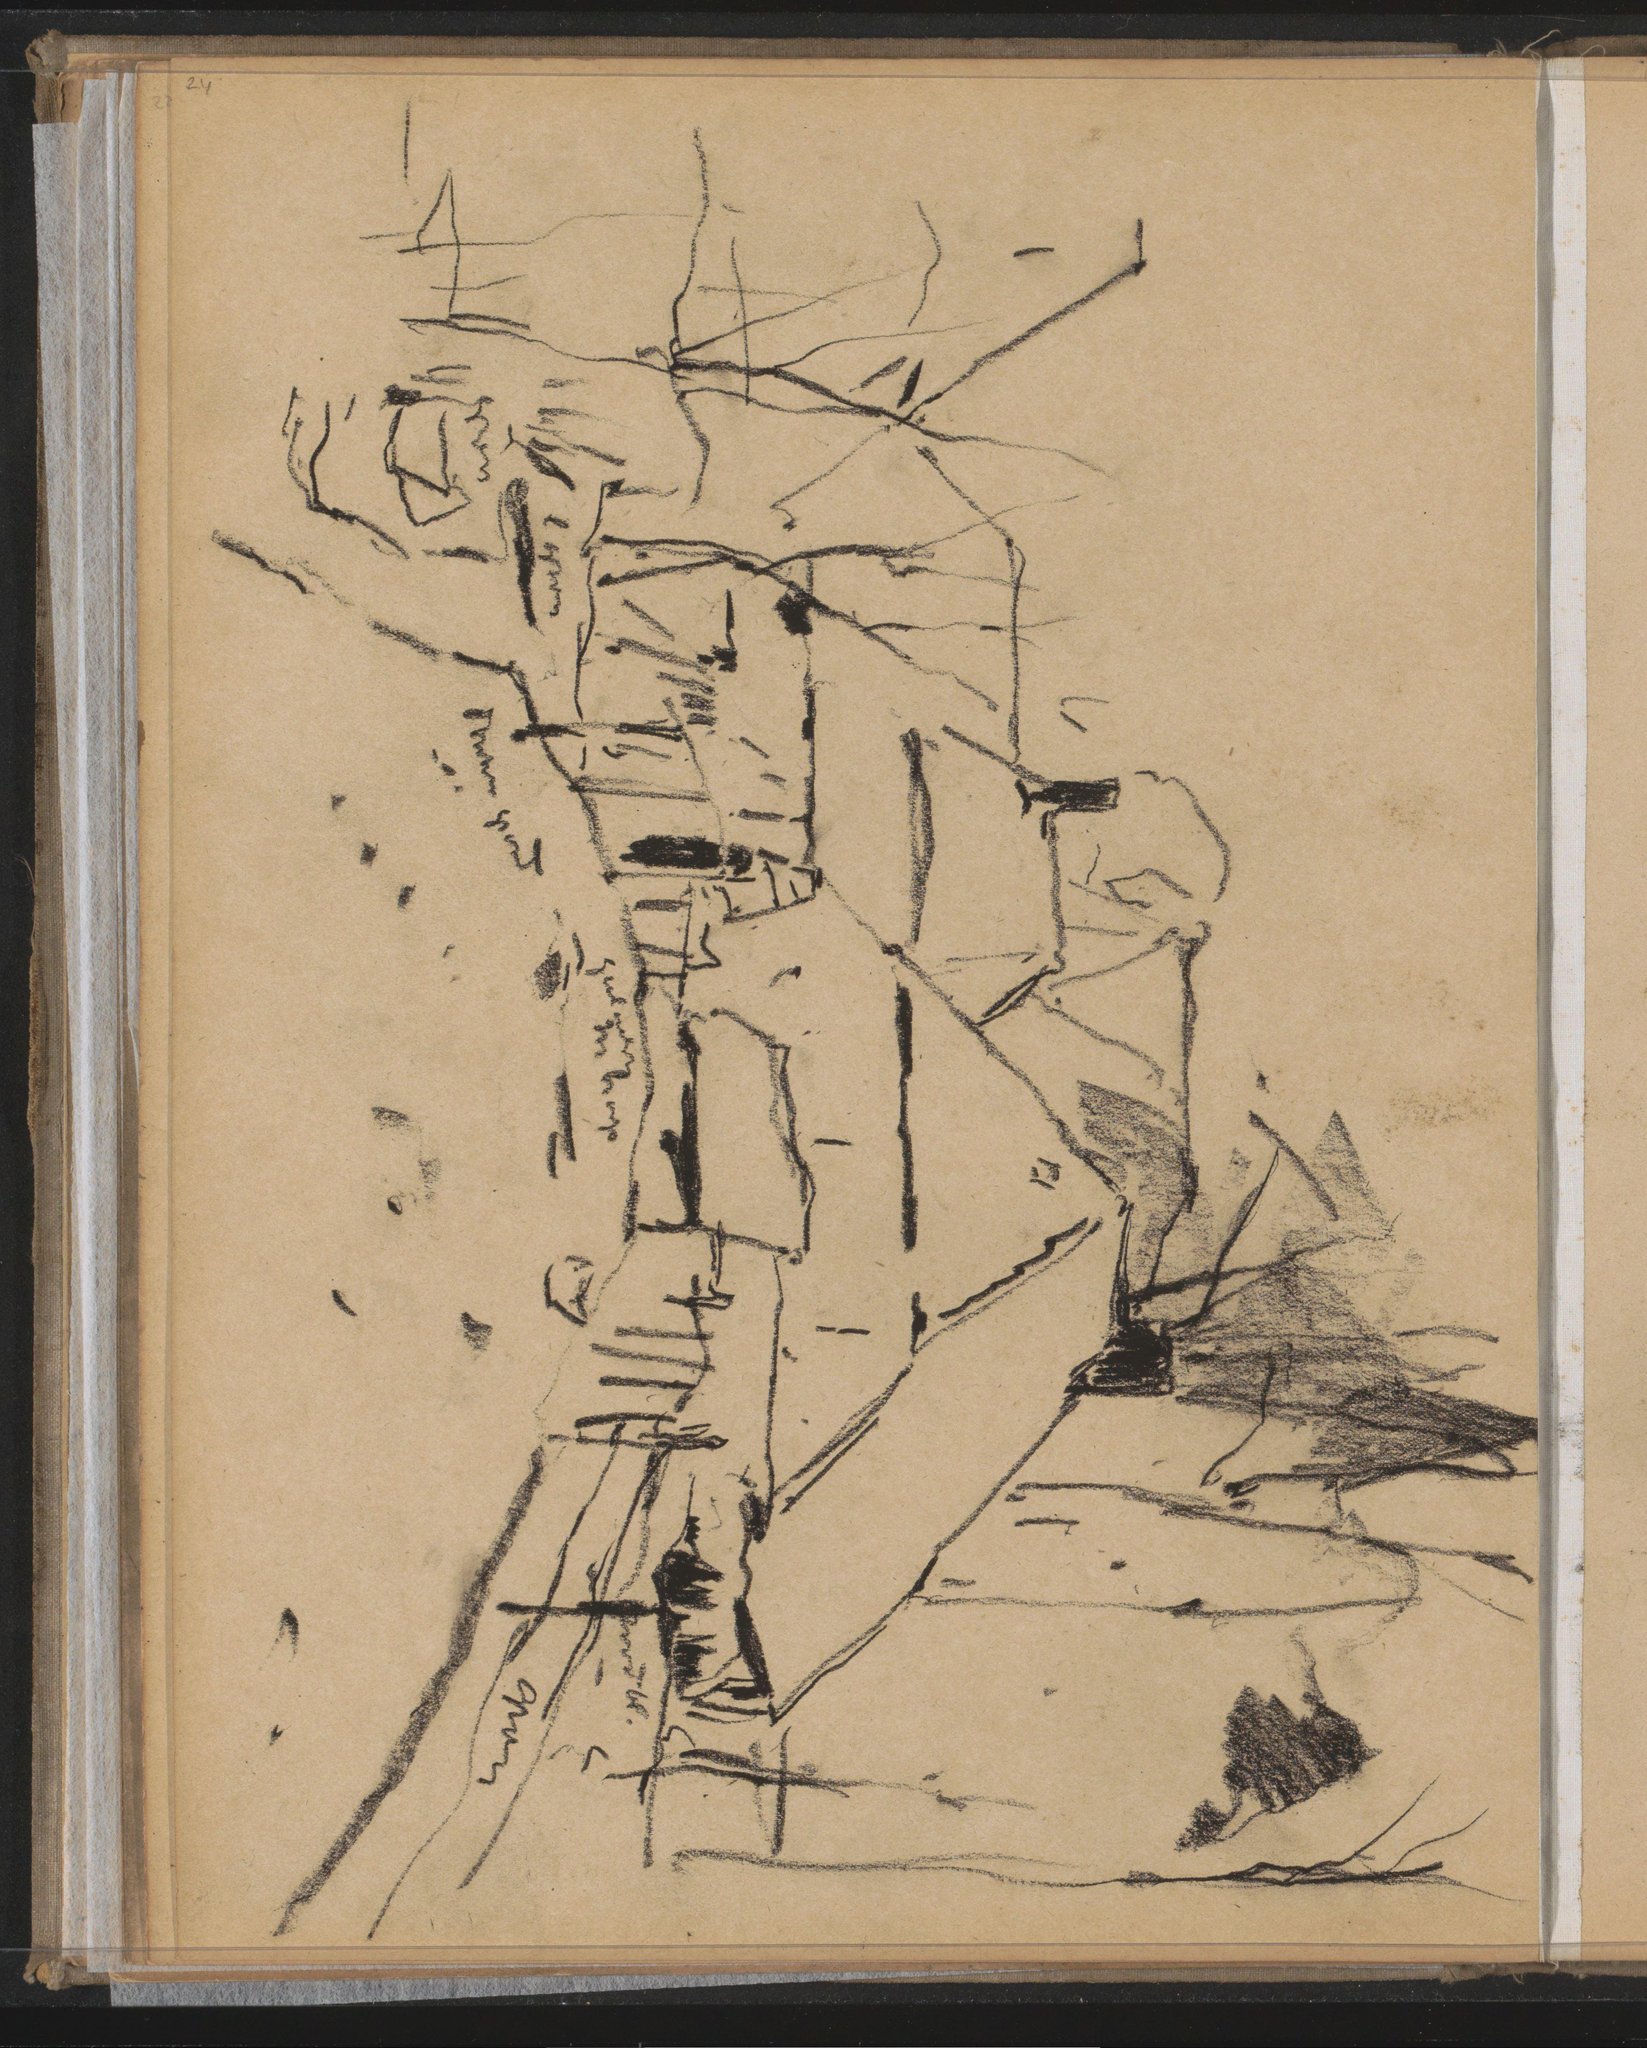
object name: sketchbook leaf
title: Boerderijen in Ede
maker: willem witsen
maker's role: draughtsman, painter, print maker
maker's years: 1860-1923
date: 1893-1897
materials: chalk, paper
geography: ede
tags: landscapes in the temperate zone, snow, farm (building)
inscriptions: kleurnotitie, handgeschreven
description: Voorstudie voor de ets 'Winteravond, Ede', ca. 1897.